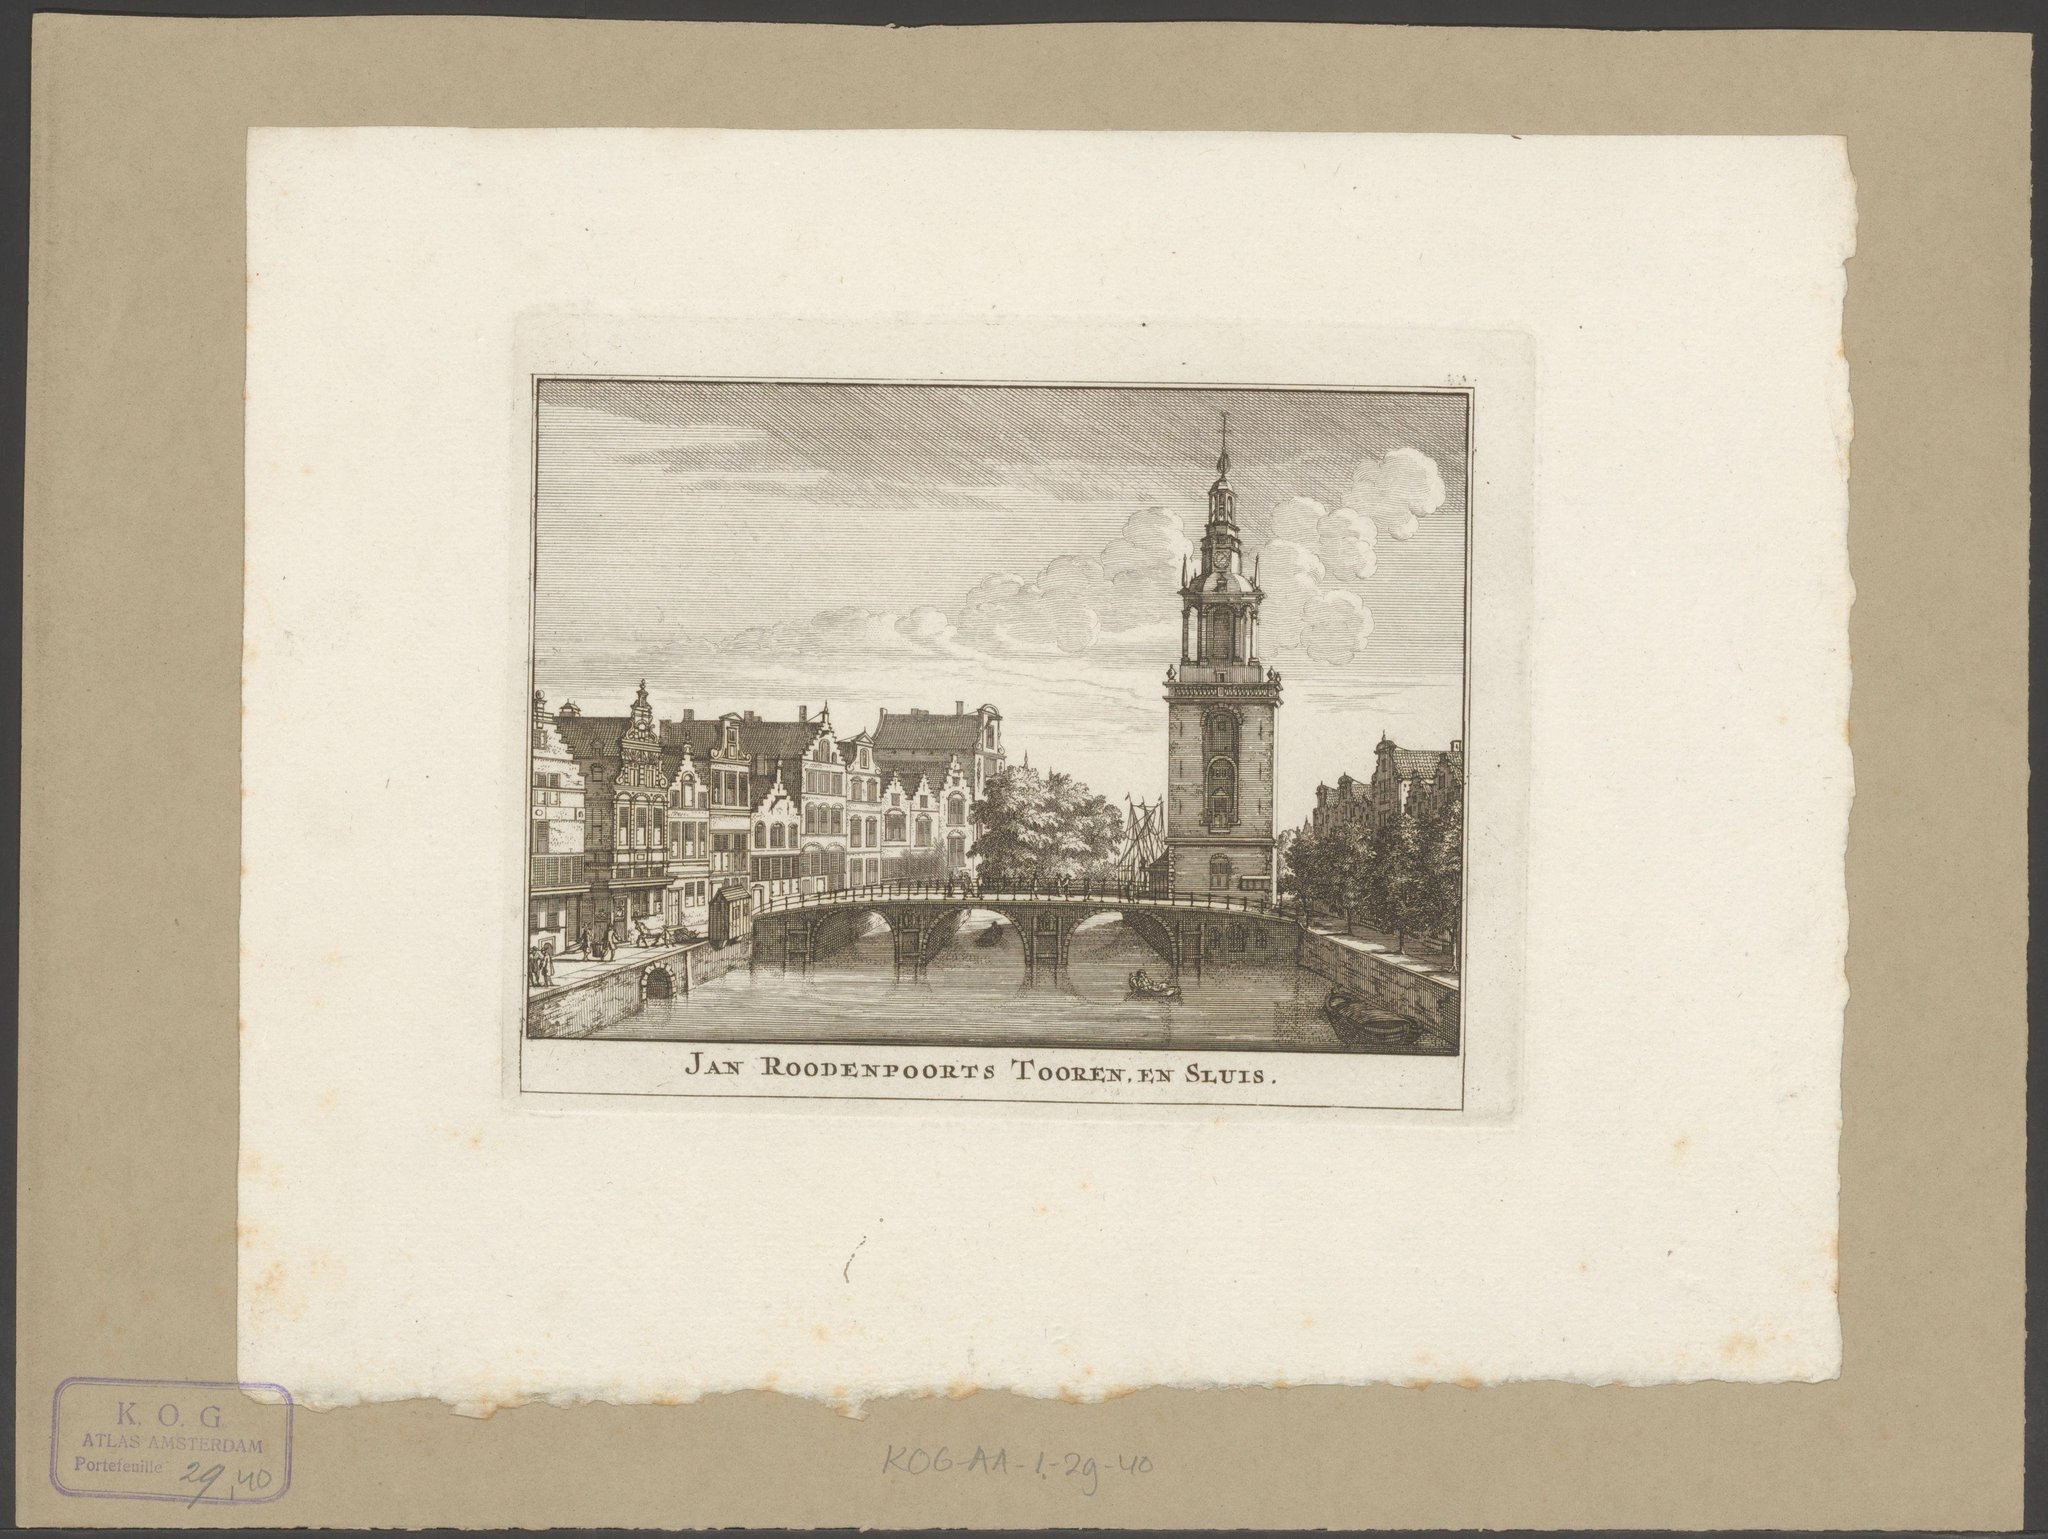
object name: print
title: Jan Roodenpoorts Tooren, en Sluis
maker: Anonymous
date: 1751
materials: paper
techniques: engraving, etching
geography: northern netherlands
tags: tower, clock tower ~ monumental adornment, rowing-boat, canoe, etc., canals, waters (in city) (+ city(-scape) with figures, staffage)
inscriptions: collector's mark: Lugt 1641b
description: Eerste staat van prent, genummerd 277, gebruikt in: Hoorn, Nicolaas ten. Wegwyzer door Amsterdam zynde eene beknopte verhandeling van desselfs eerste opkomst, vergrootingen, en teegenwoordigen staat (...). Amsterdam: Nicolaas ten Hoorn, 1713. En in: Hoorn, Nicolaas ten. Wegwyzer door Amsterdam zynde eene beknopte verhandeling van desselfs eerste opkomst, vergrootingen, en teegenwoordigen staat (...). Amsterdam: Nicolaas ten Hoorn, 1726. Tweede staat van prent, genummerd 295, gebruikt in: Hoorn, Nicolaas ten. Wegwyzer door Amsterdam zynde eene beknopte verhandeling van desselfs eerste opkomst, vergrootingen, en teegenwoordigen staat (...). Amsterdam: Nicolaas ten Hoorn, 1726. En in: Hoorn, Nicolaas ten. Wegwyzer, of korte beschryvinge van de stadt Amsterdam, zynde eene beknopte verhandeling van desselfs eerste opkomst, vergrootingen, en teegenwoordigen staat (...). Amsterdam: erven J. Ratelband & Co, 1737. En in: Hoorn, Nicolaas ten. Wegwyzer of korte beschryvinge der stad Amsterdam, zynde eene beknopte verhandeling van derzelver eerste opkomst, vergrootingen, en tegenwoordigen staat (...). Amsterdam: Pieter Meyer, 1751.